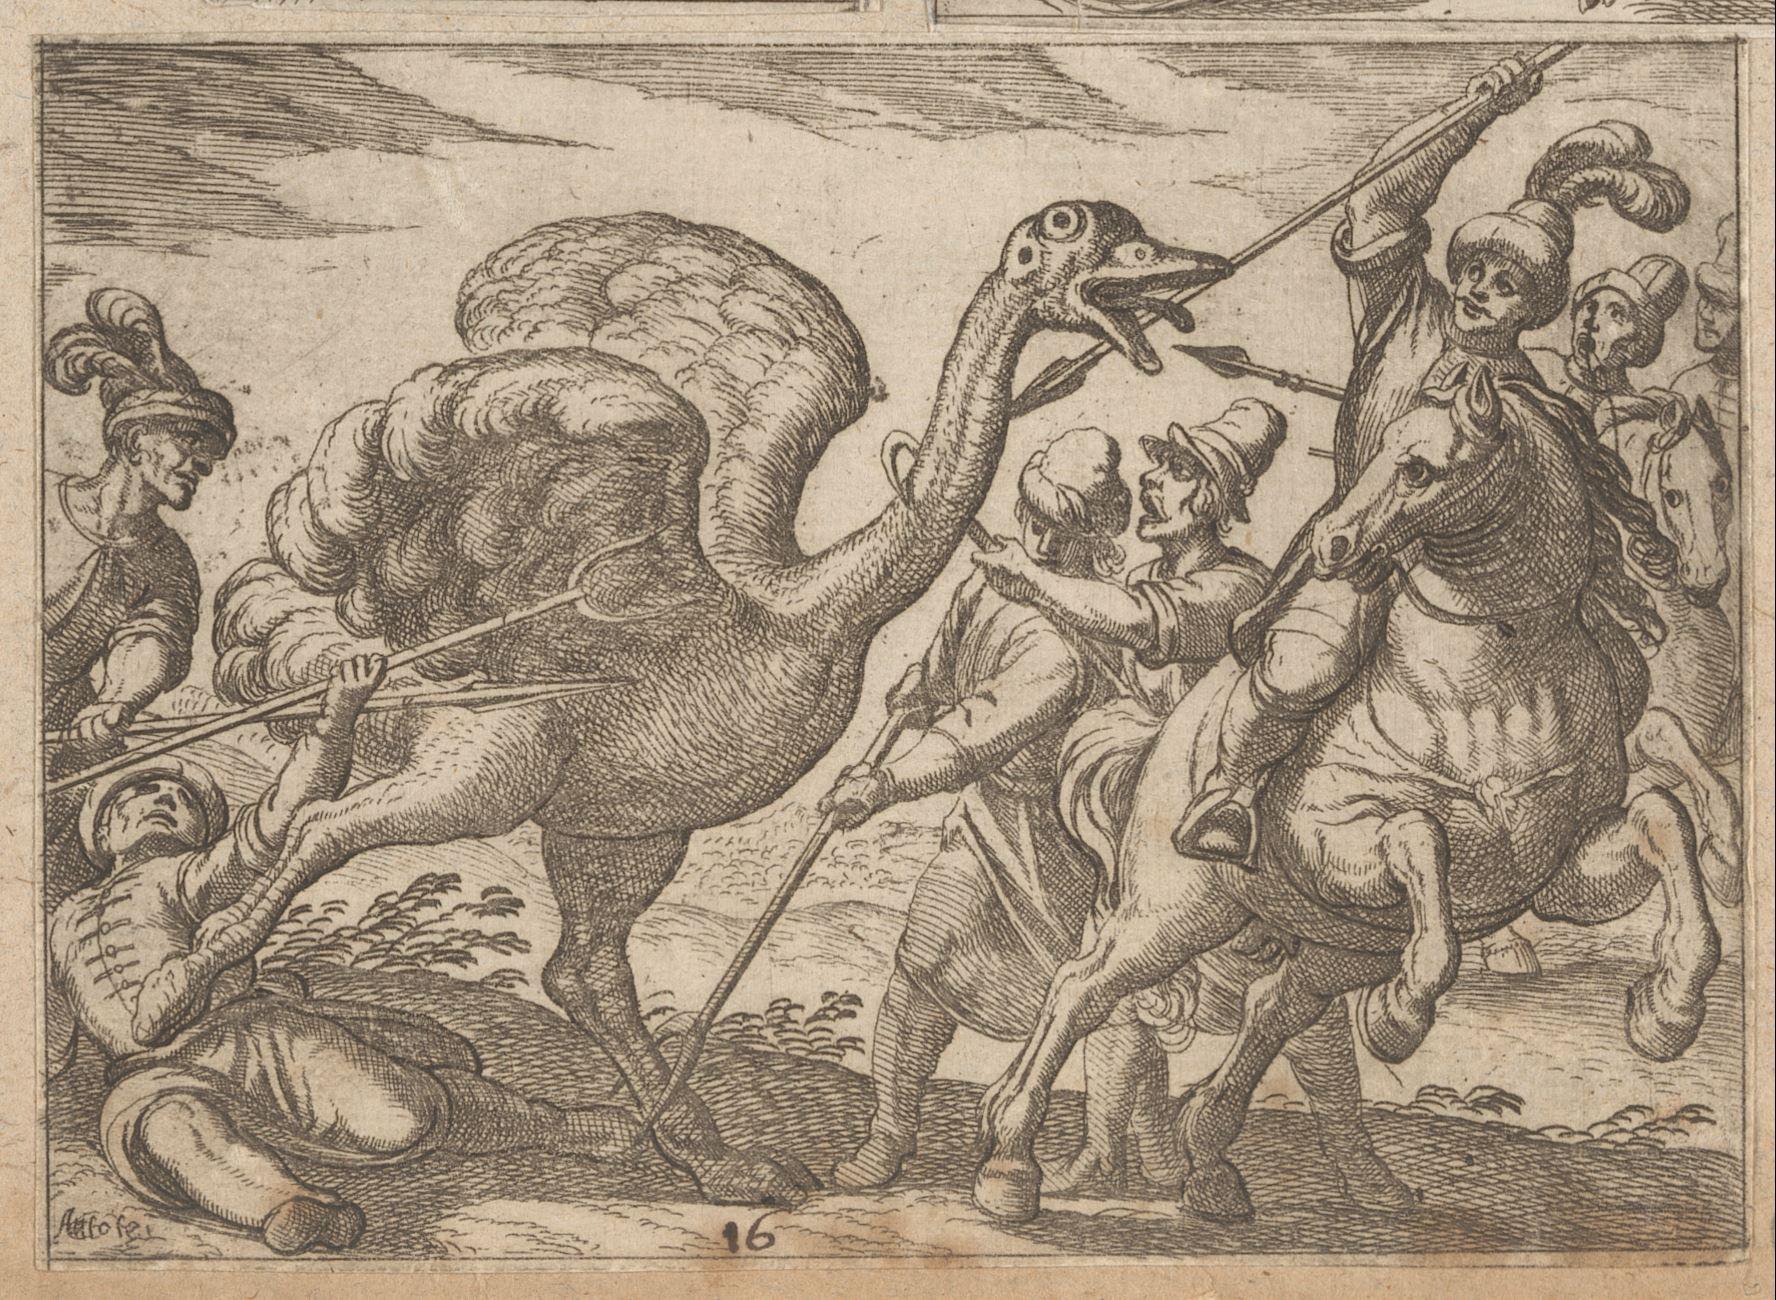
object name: print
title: Jacht op een struisvogel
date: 1598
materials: paper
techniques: etching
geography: vatican city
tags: walker and runner birds: ostrich, hunter, hunters hunting (n.b.: in 1988-1990 this notation denoted the concept of 43c11421 'hunters resting during the hunt')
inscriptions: collector's mark: ‘Hinloopen’, collector's mark: Lugt 11, number: ‘16’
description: Deze prent maakt deel uit van een reeks van 45 jachtscènes (+ titelprent en opdracht).